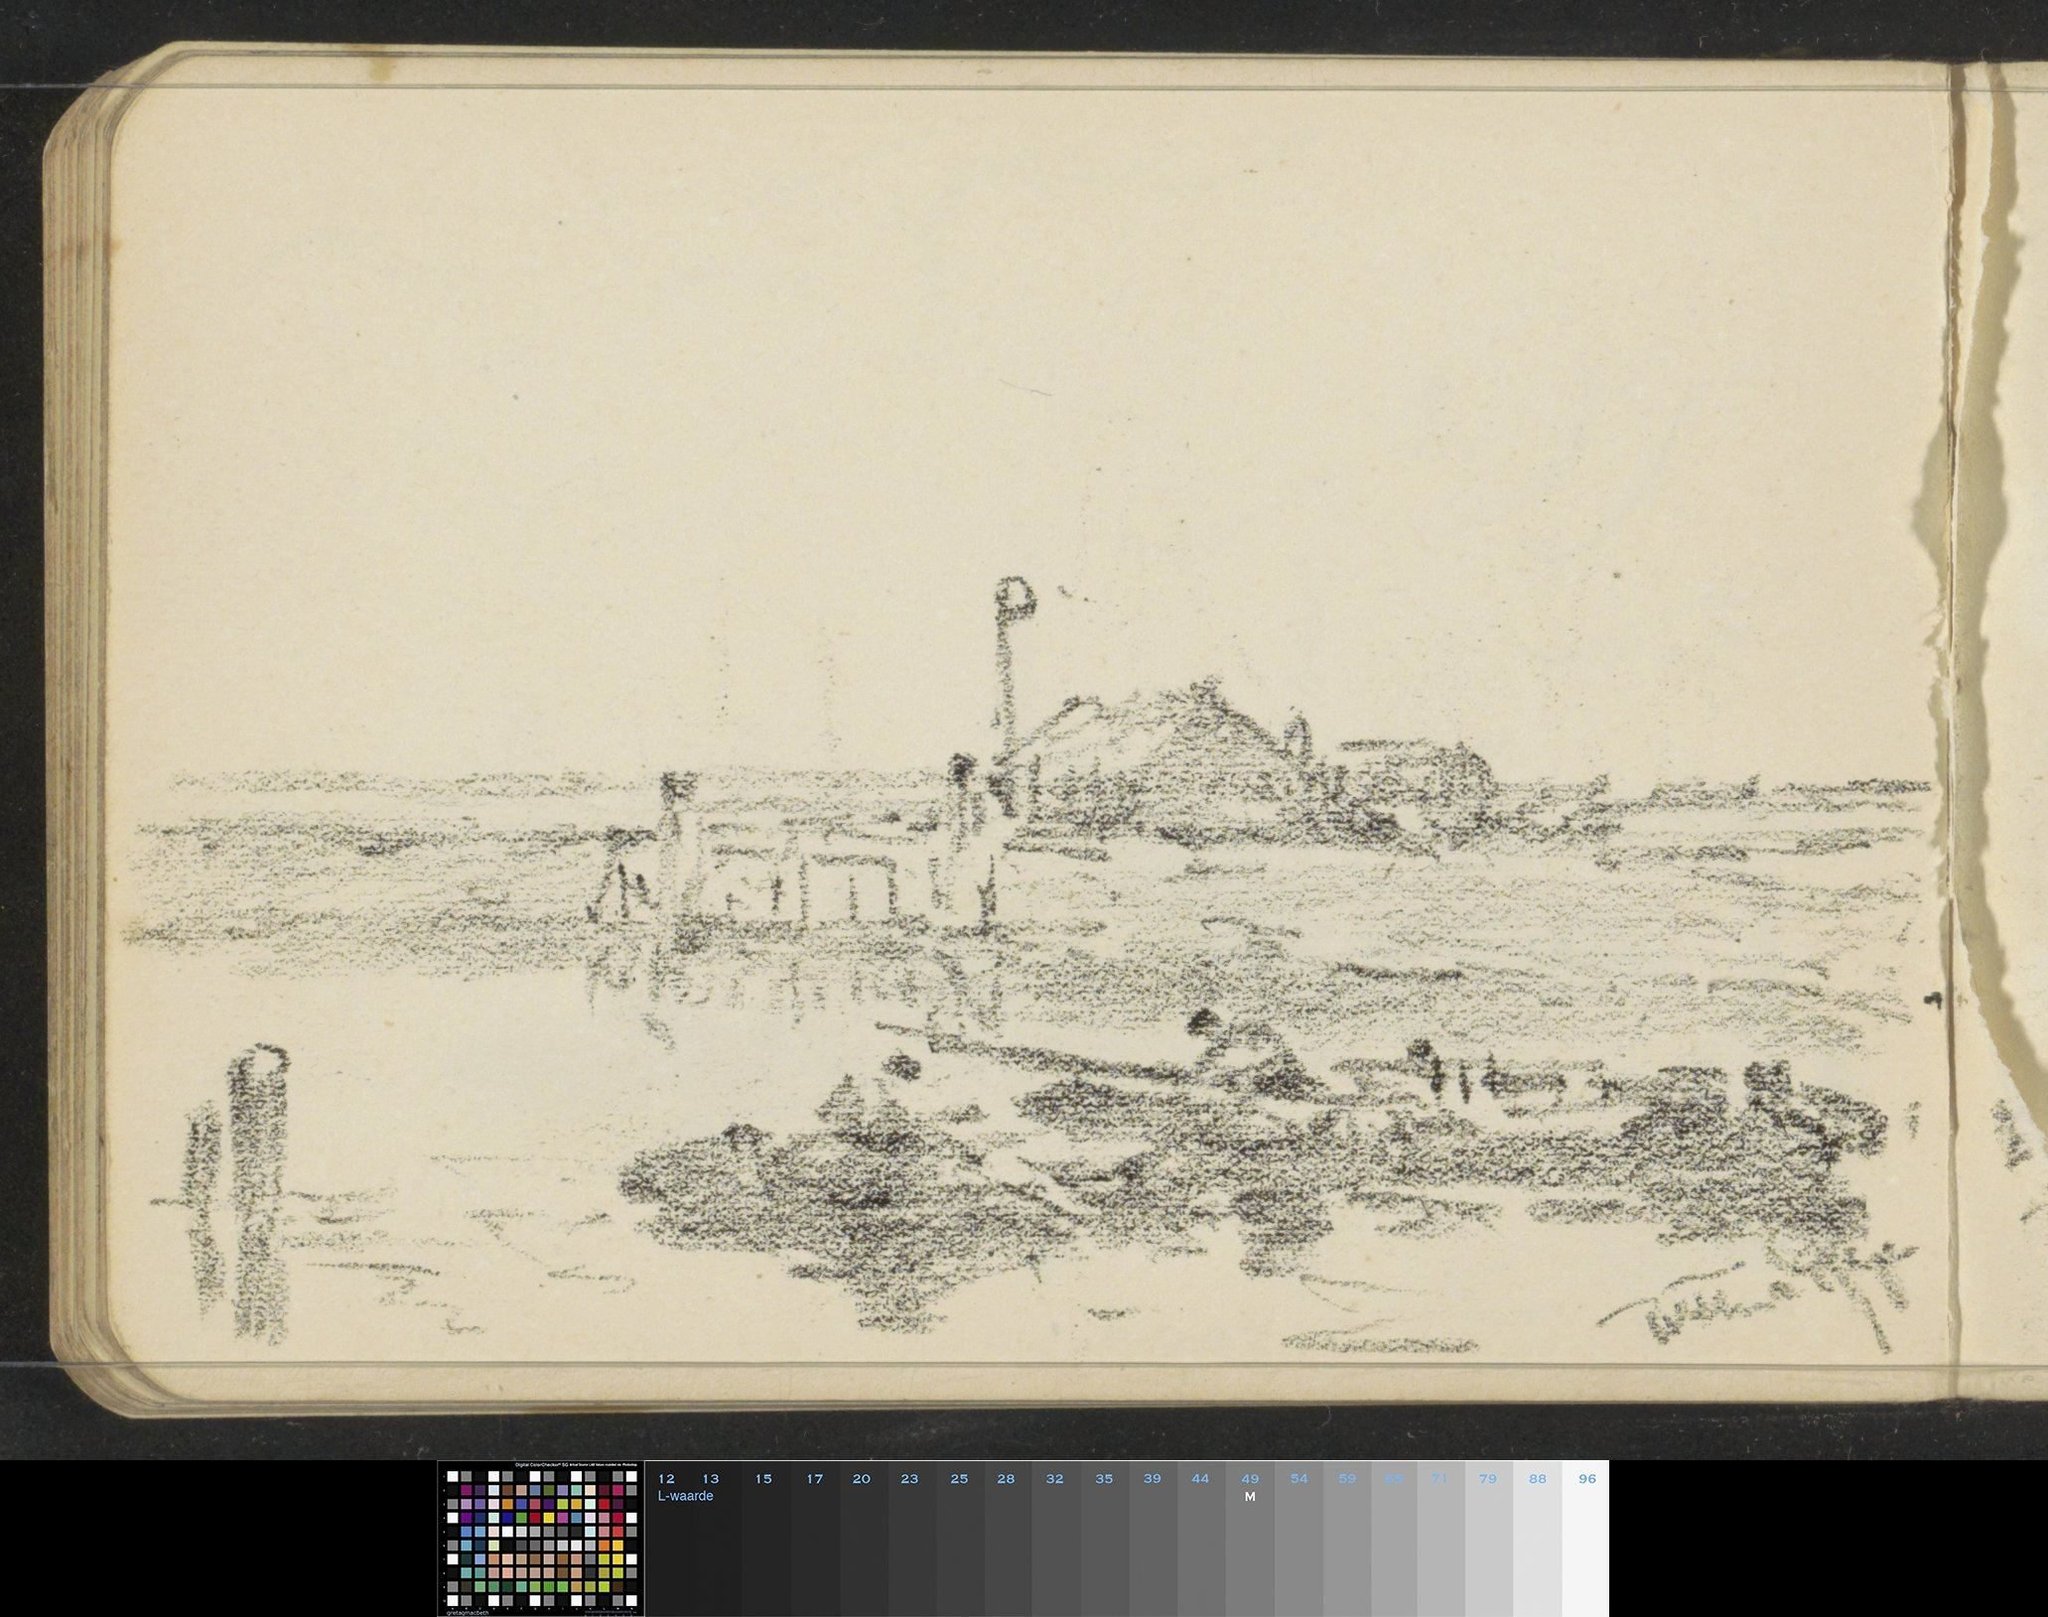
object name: sketchbook leaf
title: Vissers op een golfbreker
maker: willem cornelis rip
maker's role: draughtsman, painter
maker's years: 1856-1922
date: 1914-1916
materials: chalk, paper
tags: coastal protection work, breakwater, coast (+ landscape with figures, staffage)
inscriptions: signature: ‘Willem c Rip’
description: Op de achtergrond een kust en huis. Blad 40 verso uit een schetsboek met 41 bladen.